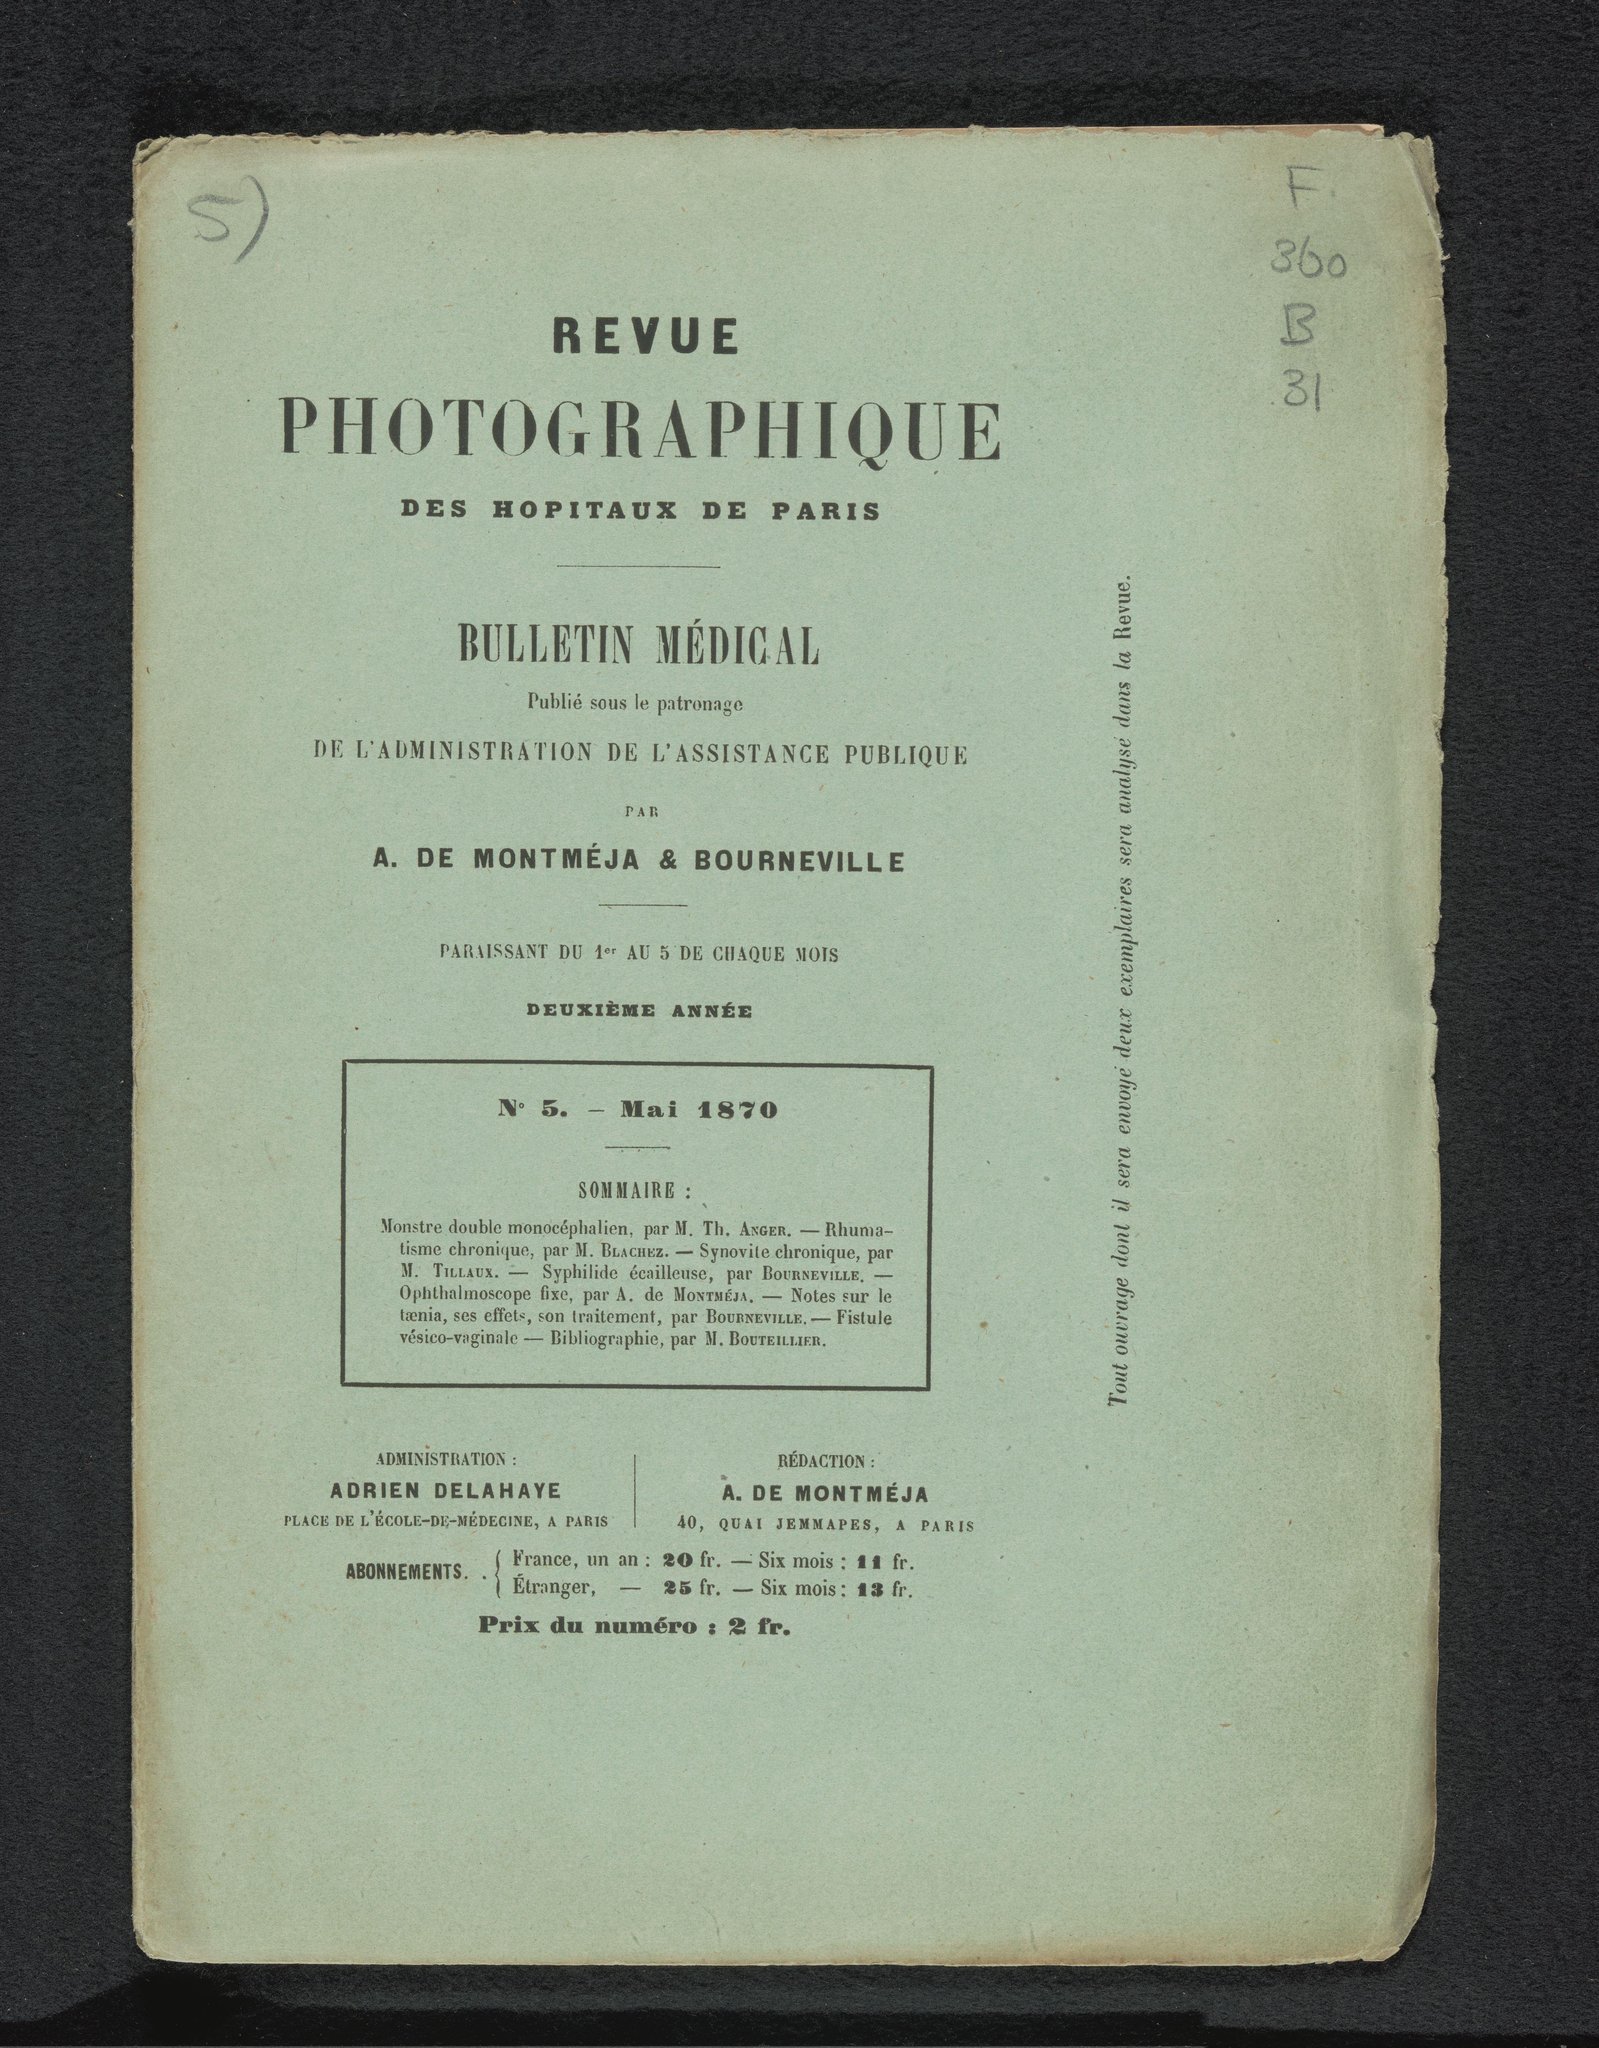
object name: magazine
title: Revue photographique des hôpitaux de Paris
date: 1870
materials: paper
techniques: printing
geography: paris